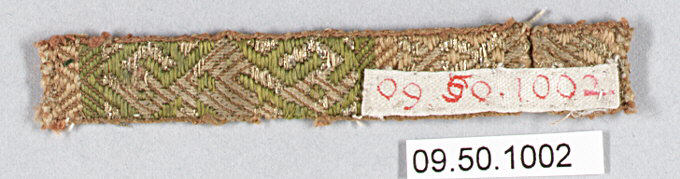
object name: gimp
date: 1401-1600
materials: metal thread, silk